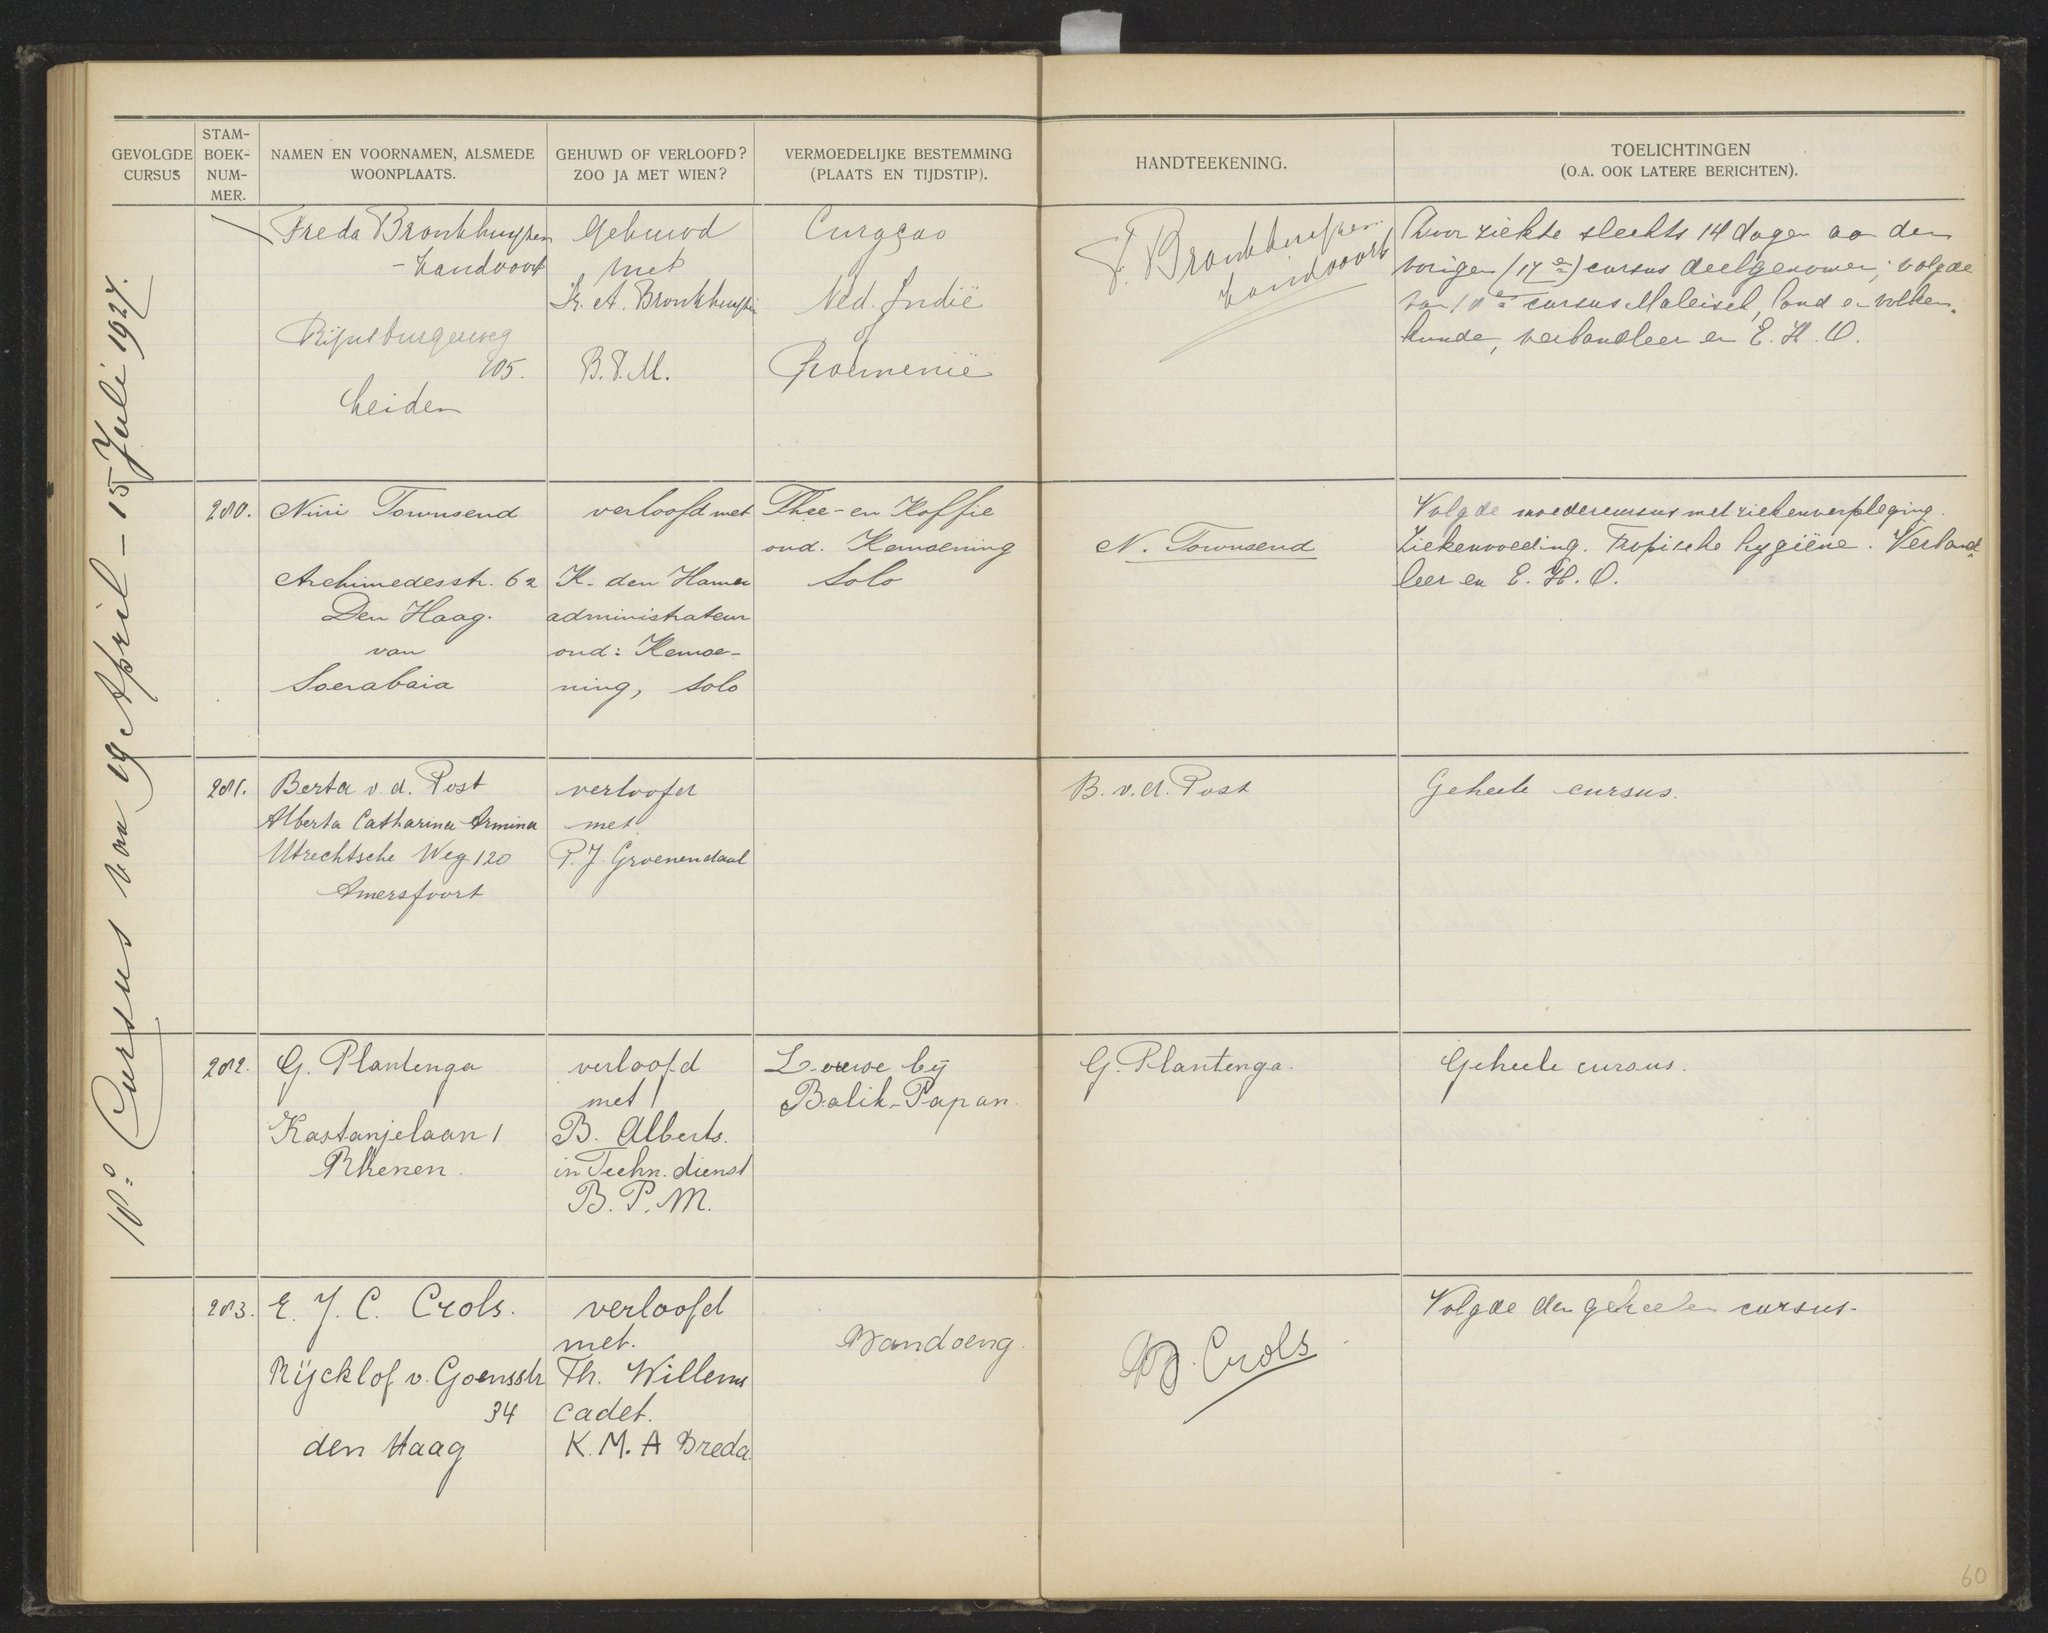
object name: album leaf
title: Blad 60 uit Stamboek van de leerlingen der Koloniale School voor Meisjes en Vrouwen te 's-Gravenhage deel I (1921-1929)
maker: Anonymous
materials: paper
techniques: printing, writing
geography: the hague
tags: further education (+ pupil), further education, the hague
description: Twee pagina's met gegevens van de deelnemers aan de 18e driemaandelijkse cursus van 19 april tot en met 15 juli 1927, stamboeknummers 280 tot en met 283. Onderdeel van Stamboek van de leerlingen der Koloniale School voor Meisjes en Vrouwen te 's-Gravenhage deel I (1921-1929).